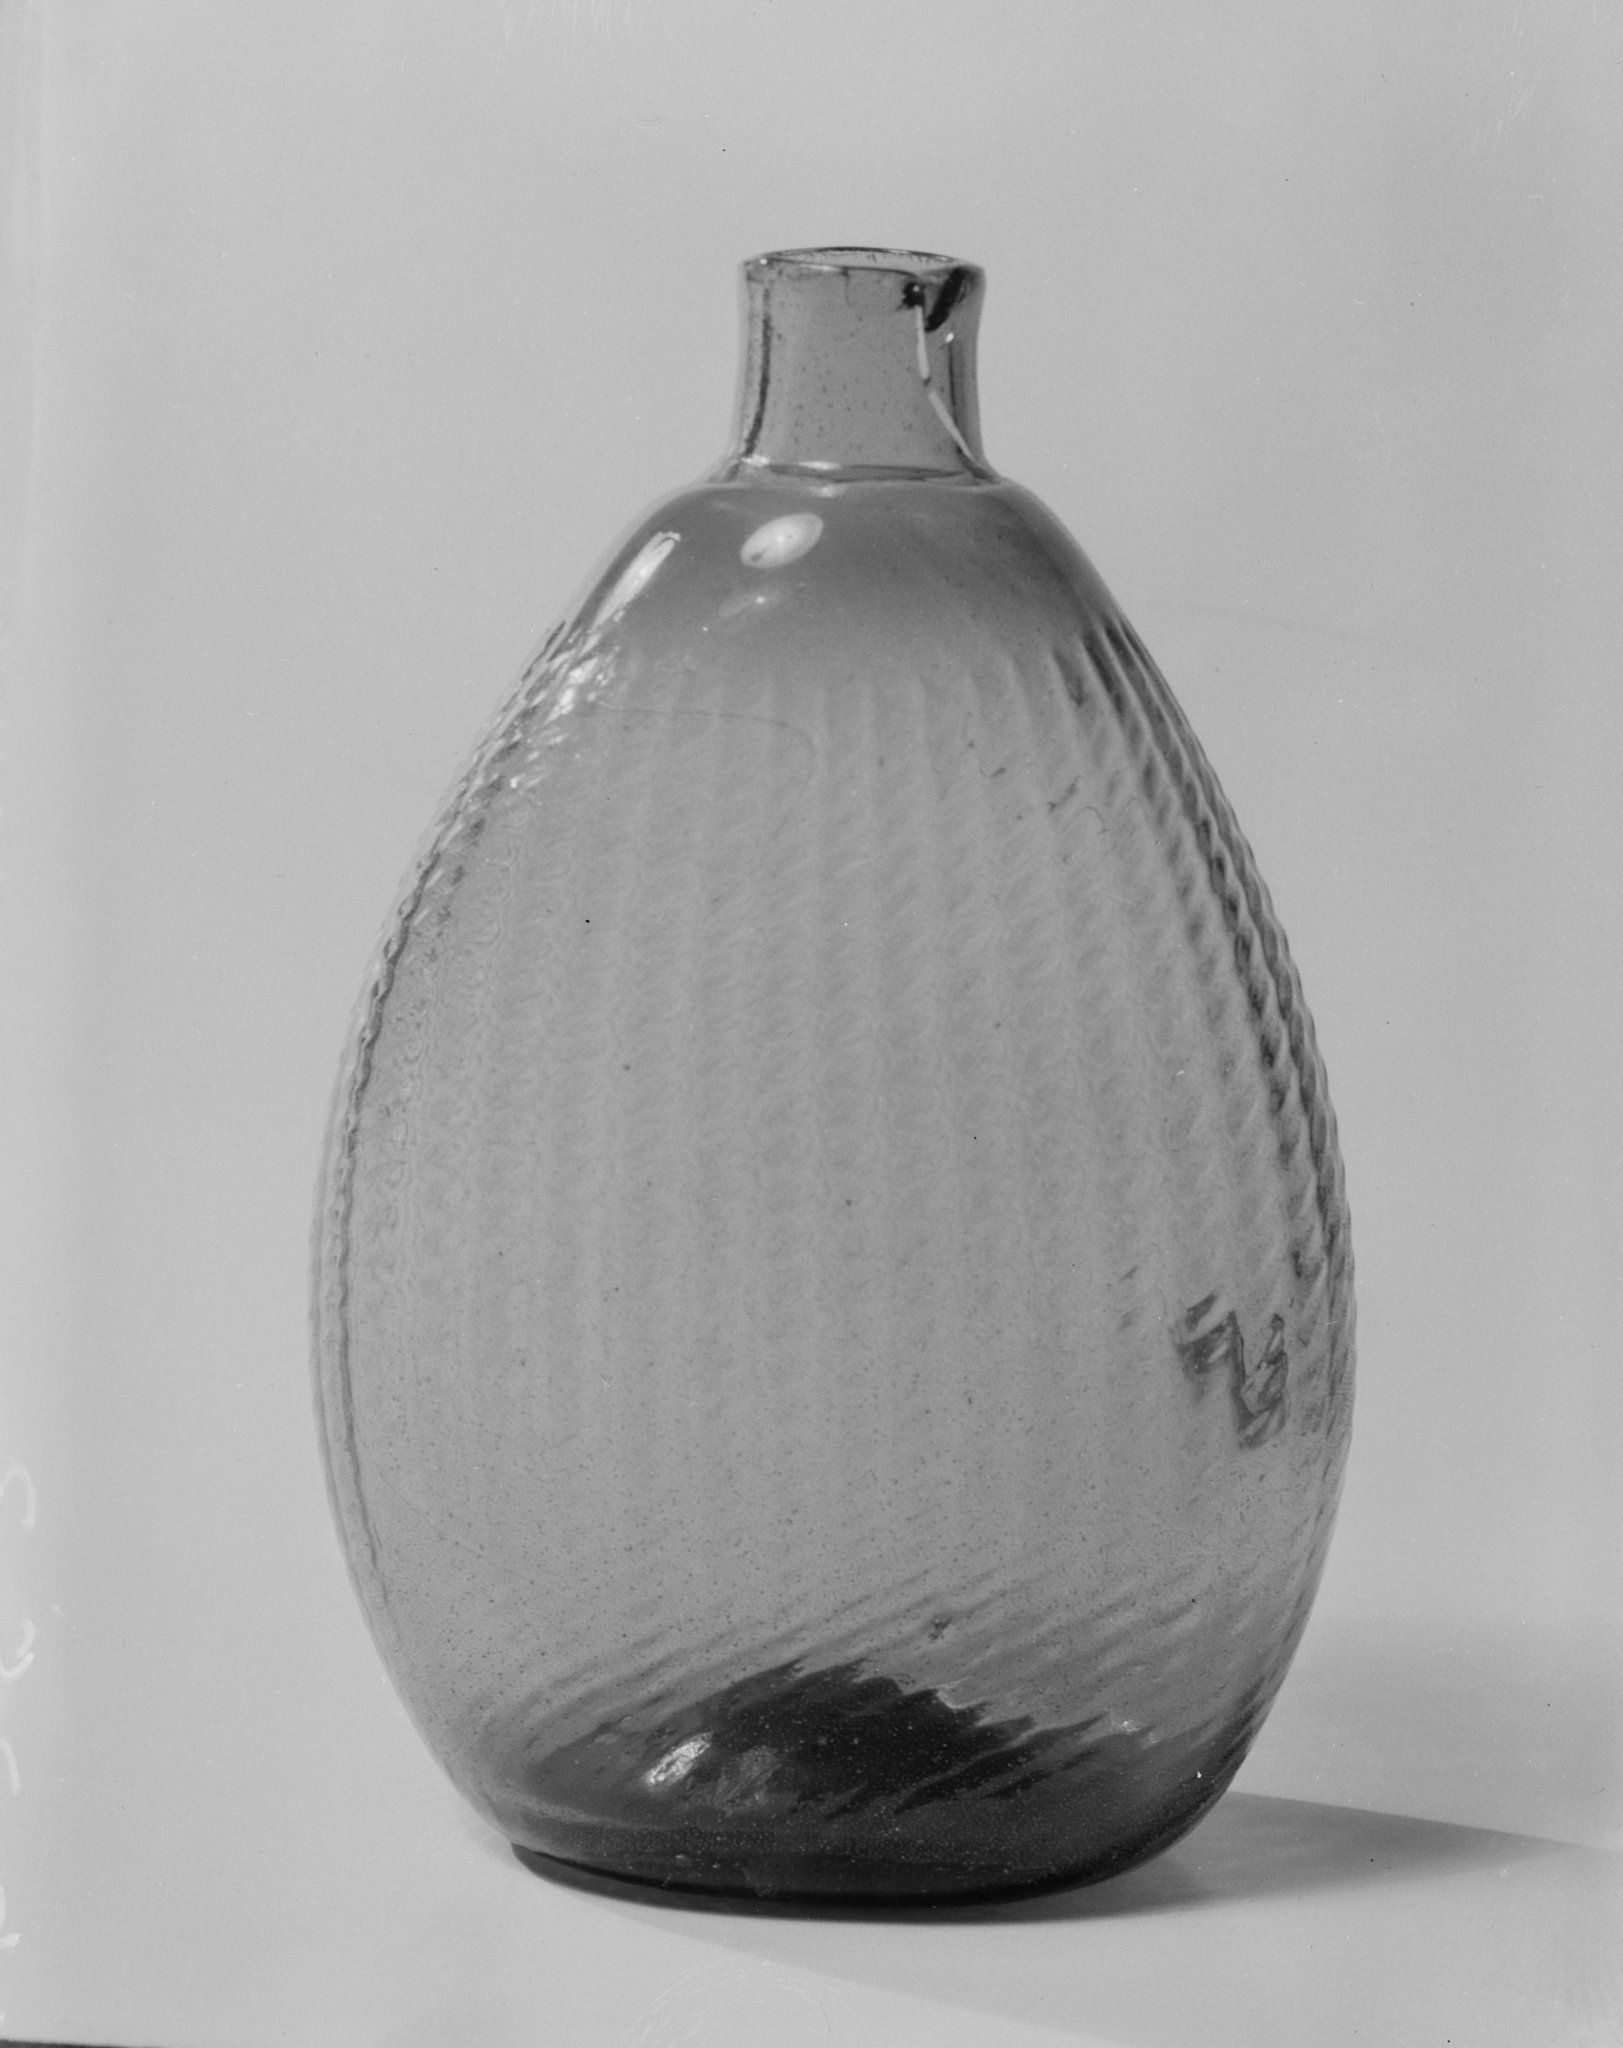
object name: flask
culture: american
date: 1770-1830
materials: glass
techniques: glassblowing, molding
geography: united states